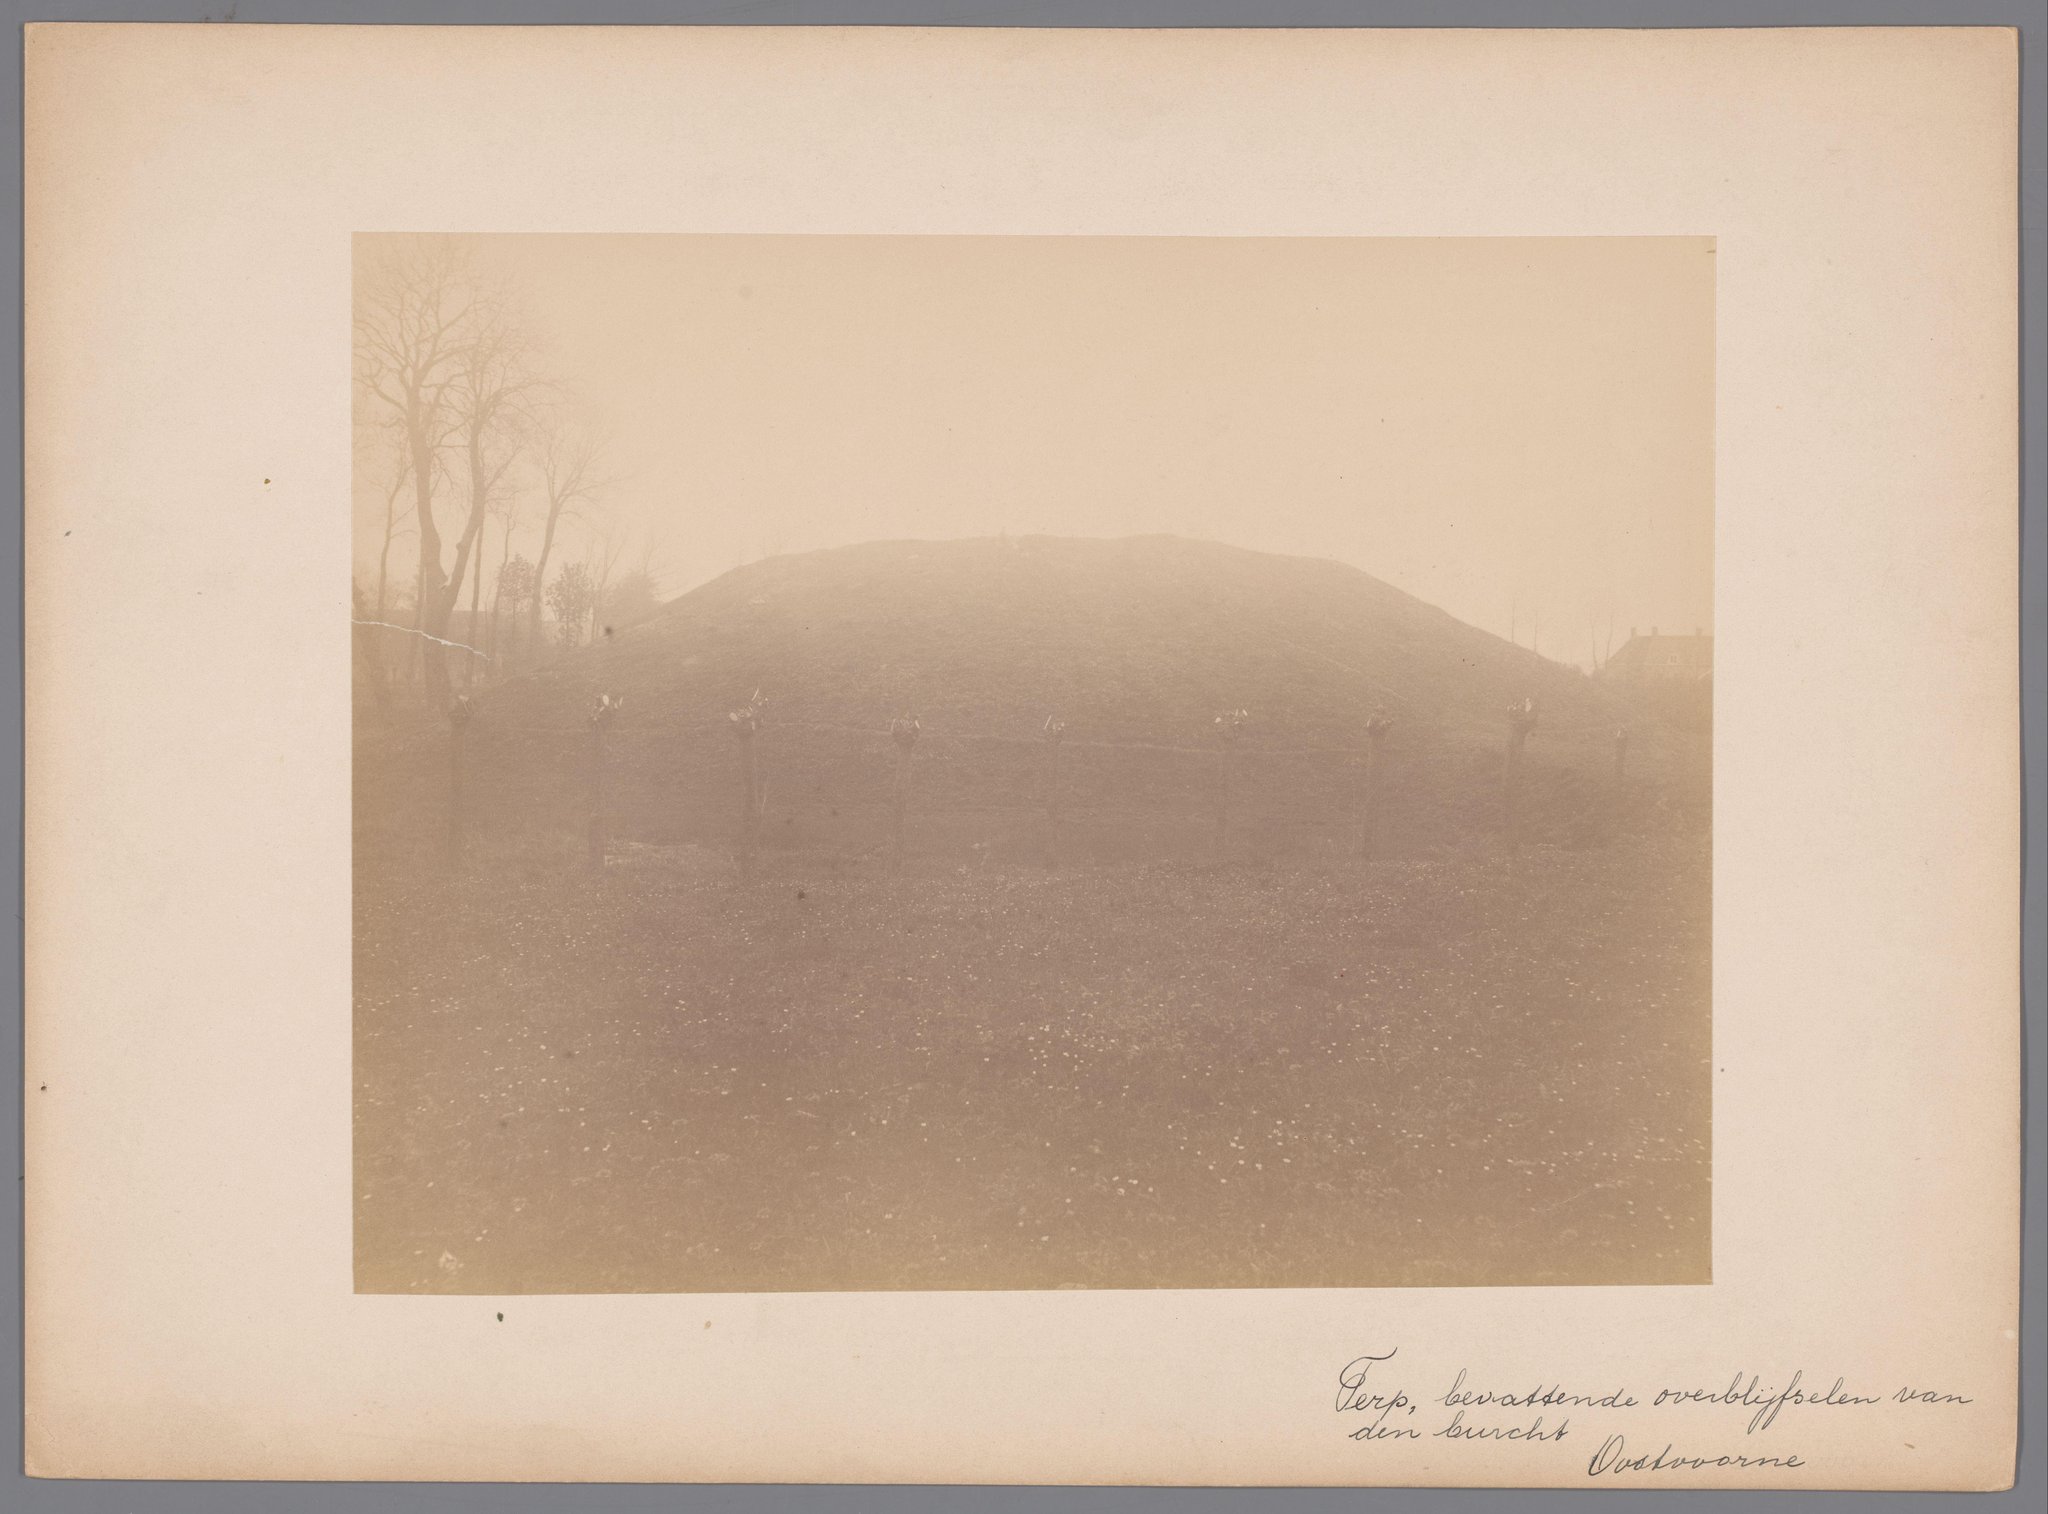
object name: photograph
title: Terp met de overblijfselen van de burcht van Oostvoorne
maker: anoniem (monumentenzorg)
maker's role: fotograaf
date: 1890-1920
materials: cardboard, photographic support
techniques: albumen print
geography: oostvoorne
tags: mound, verge, oostvoorne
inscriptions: annotation: ‘Oostvoorne/ Terp, bevattende overblijfsel van burcht’, annotation: ‘Terp, bevattende overblijfselen van den burcht/ Oostvoorne’